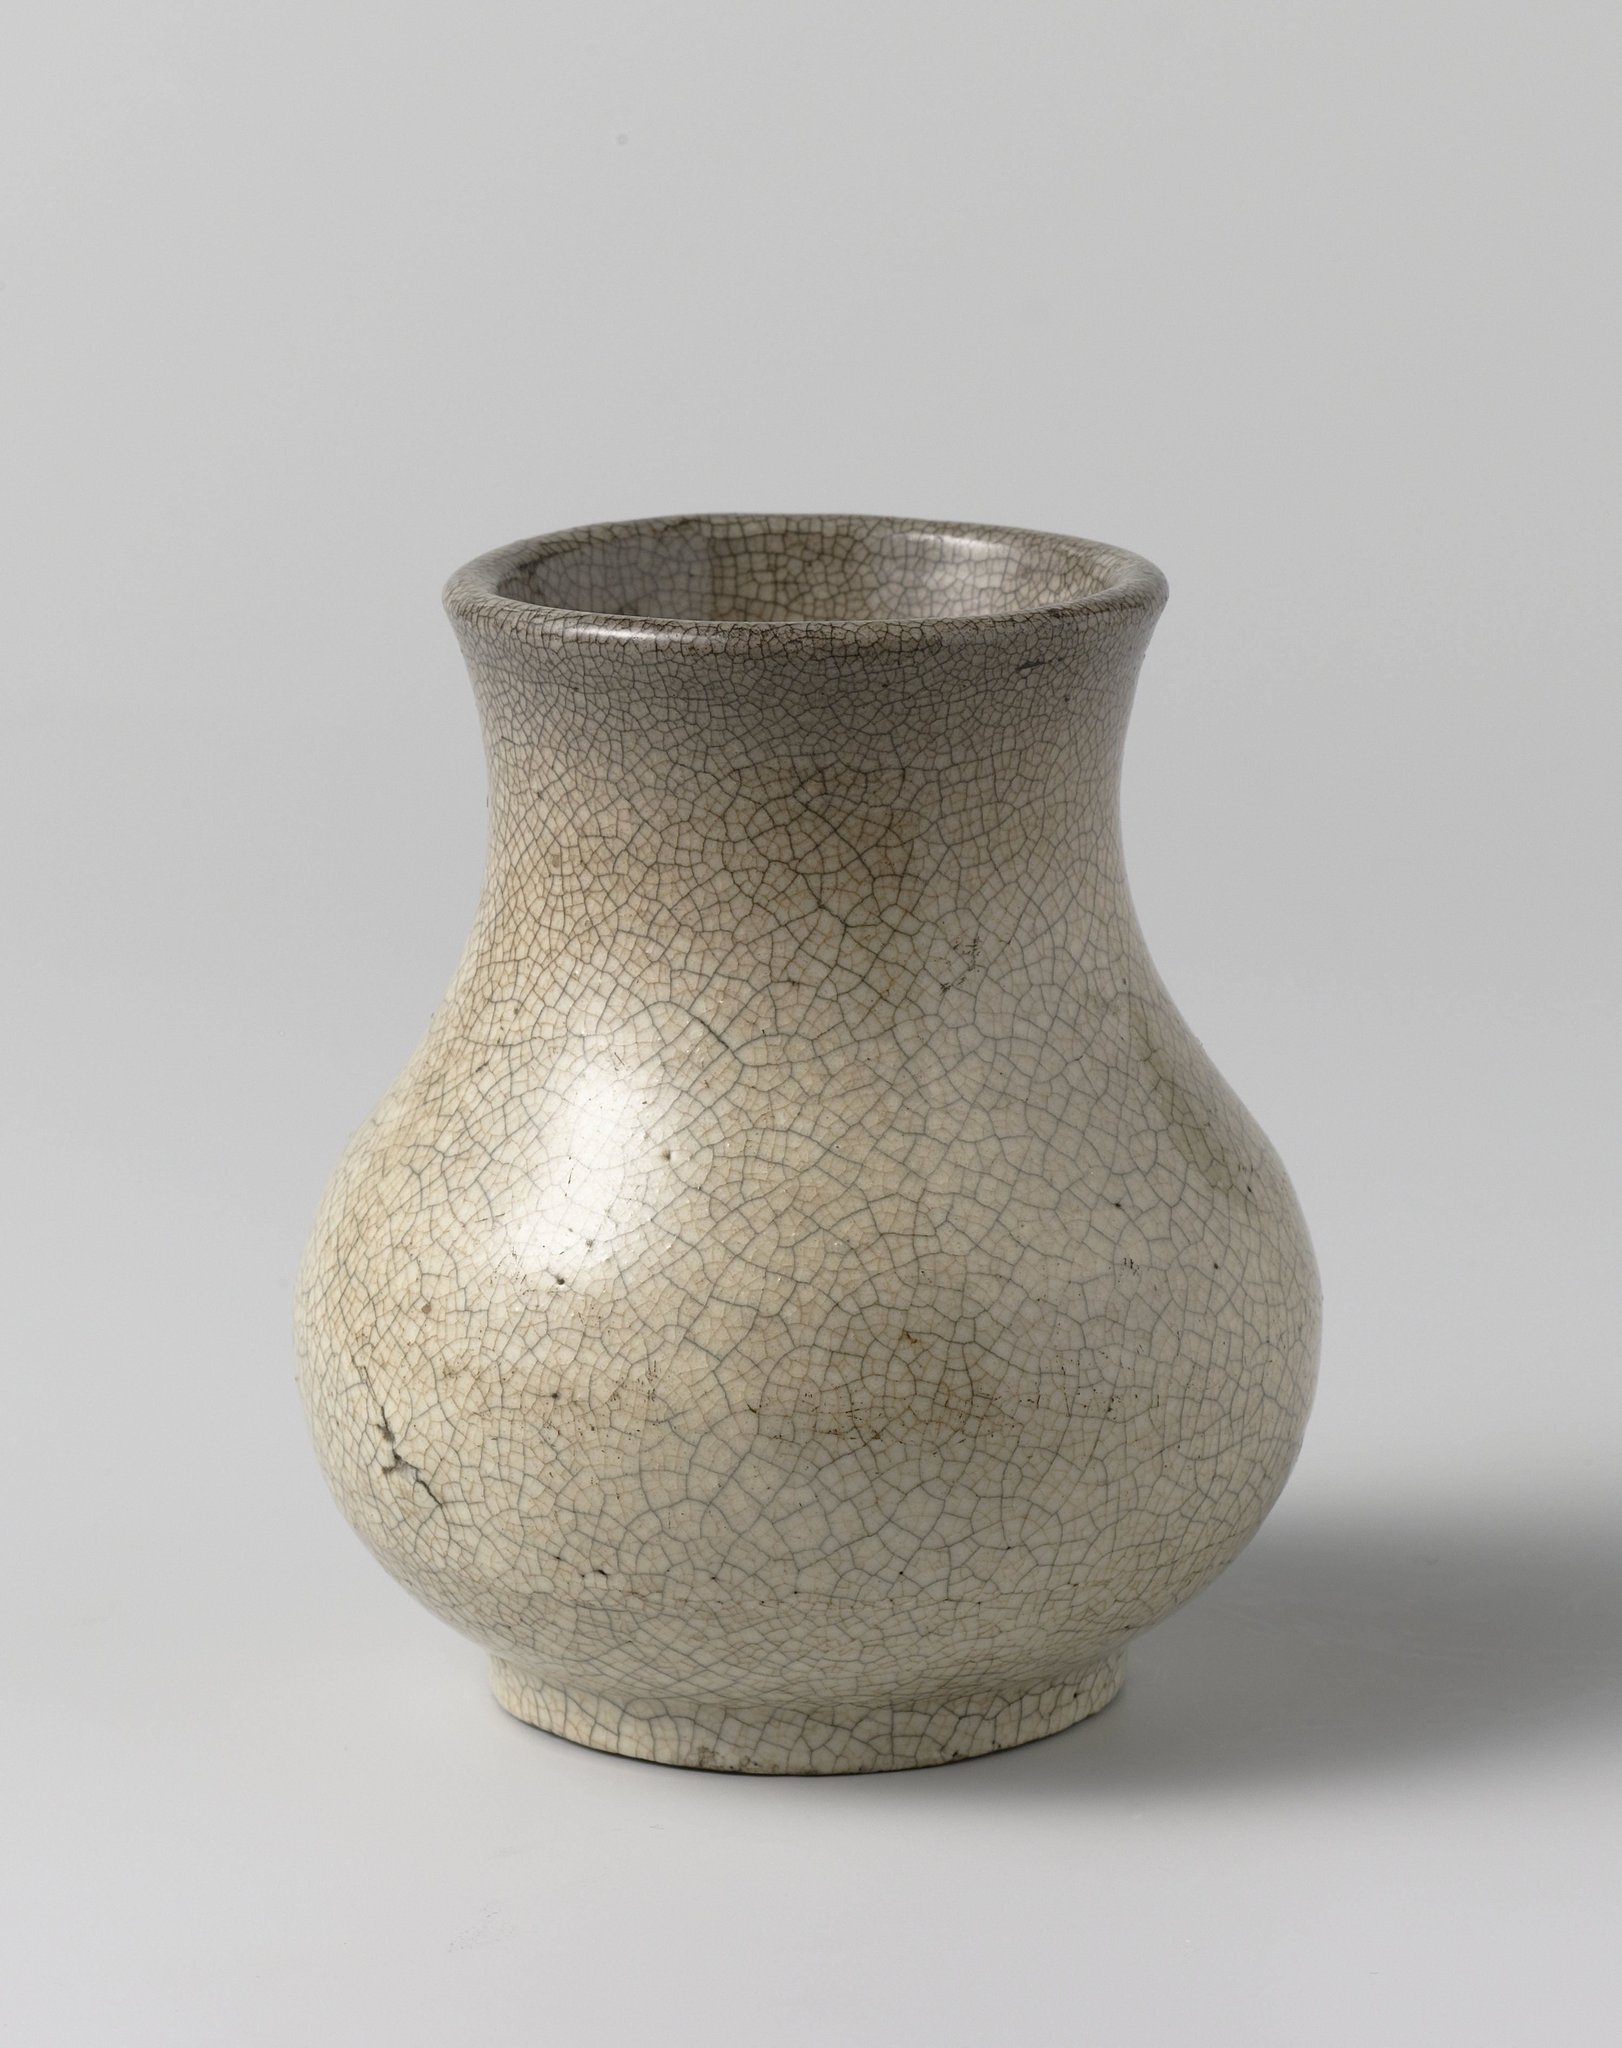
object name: vase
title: Vase with a crackled cream glaze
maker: Anonymous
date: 1600-1699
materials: glaze, stoneware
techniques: firing, turning, vitrification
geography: japan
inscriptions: label: ‘Chosen-Karatsu/ 16th’, label: ‘W696’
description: Peervormige vaas van steengoed met een wijde, spreidende nek, bedekt met een gecraqueleerd crèmekleurig glazuur. Twee oude label op de onderzijde met 'Chosen-Karatsu/ 16th' en 'W696'. Karatsu.